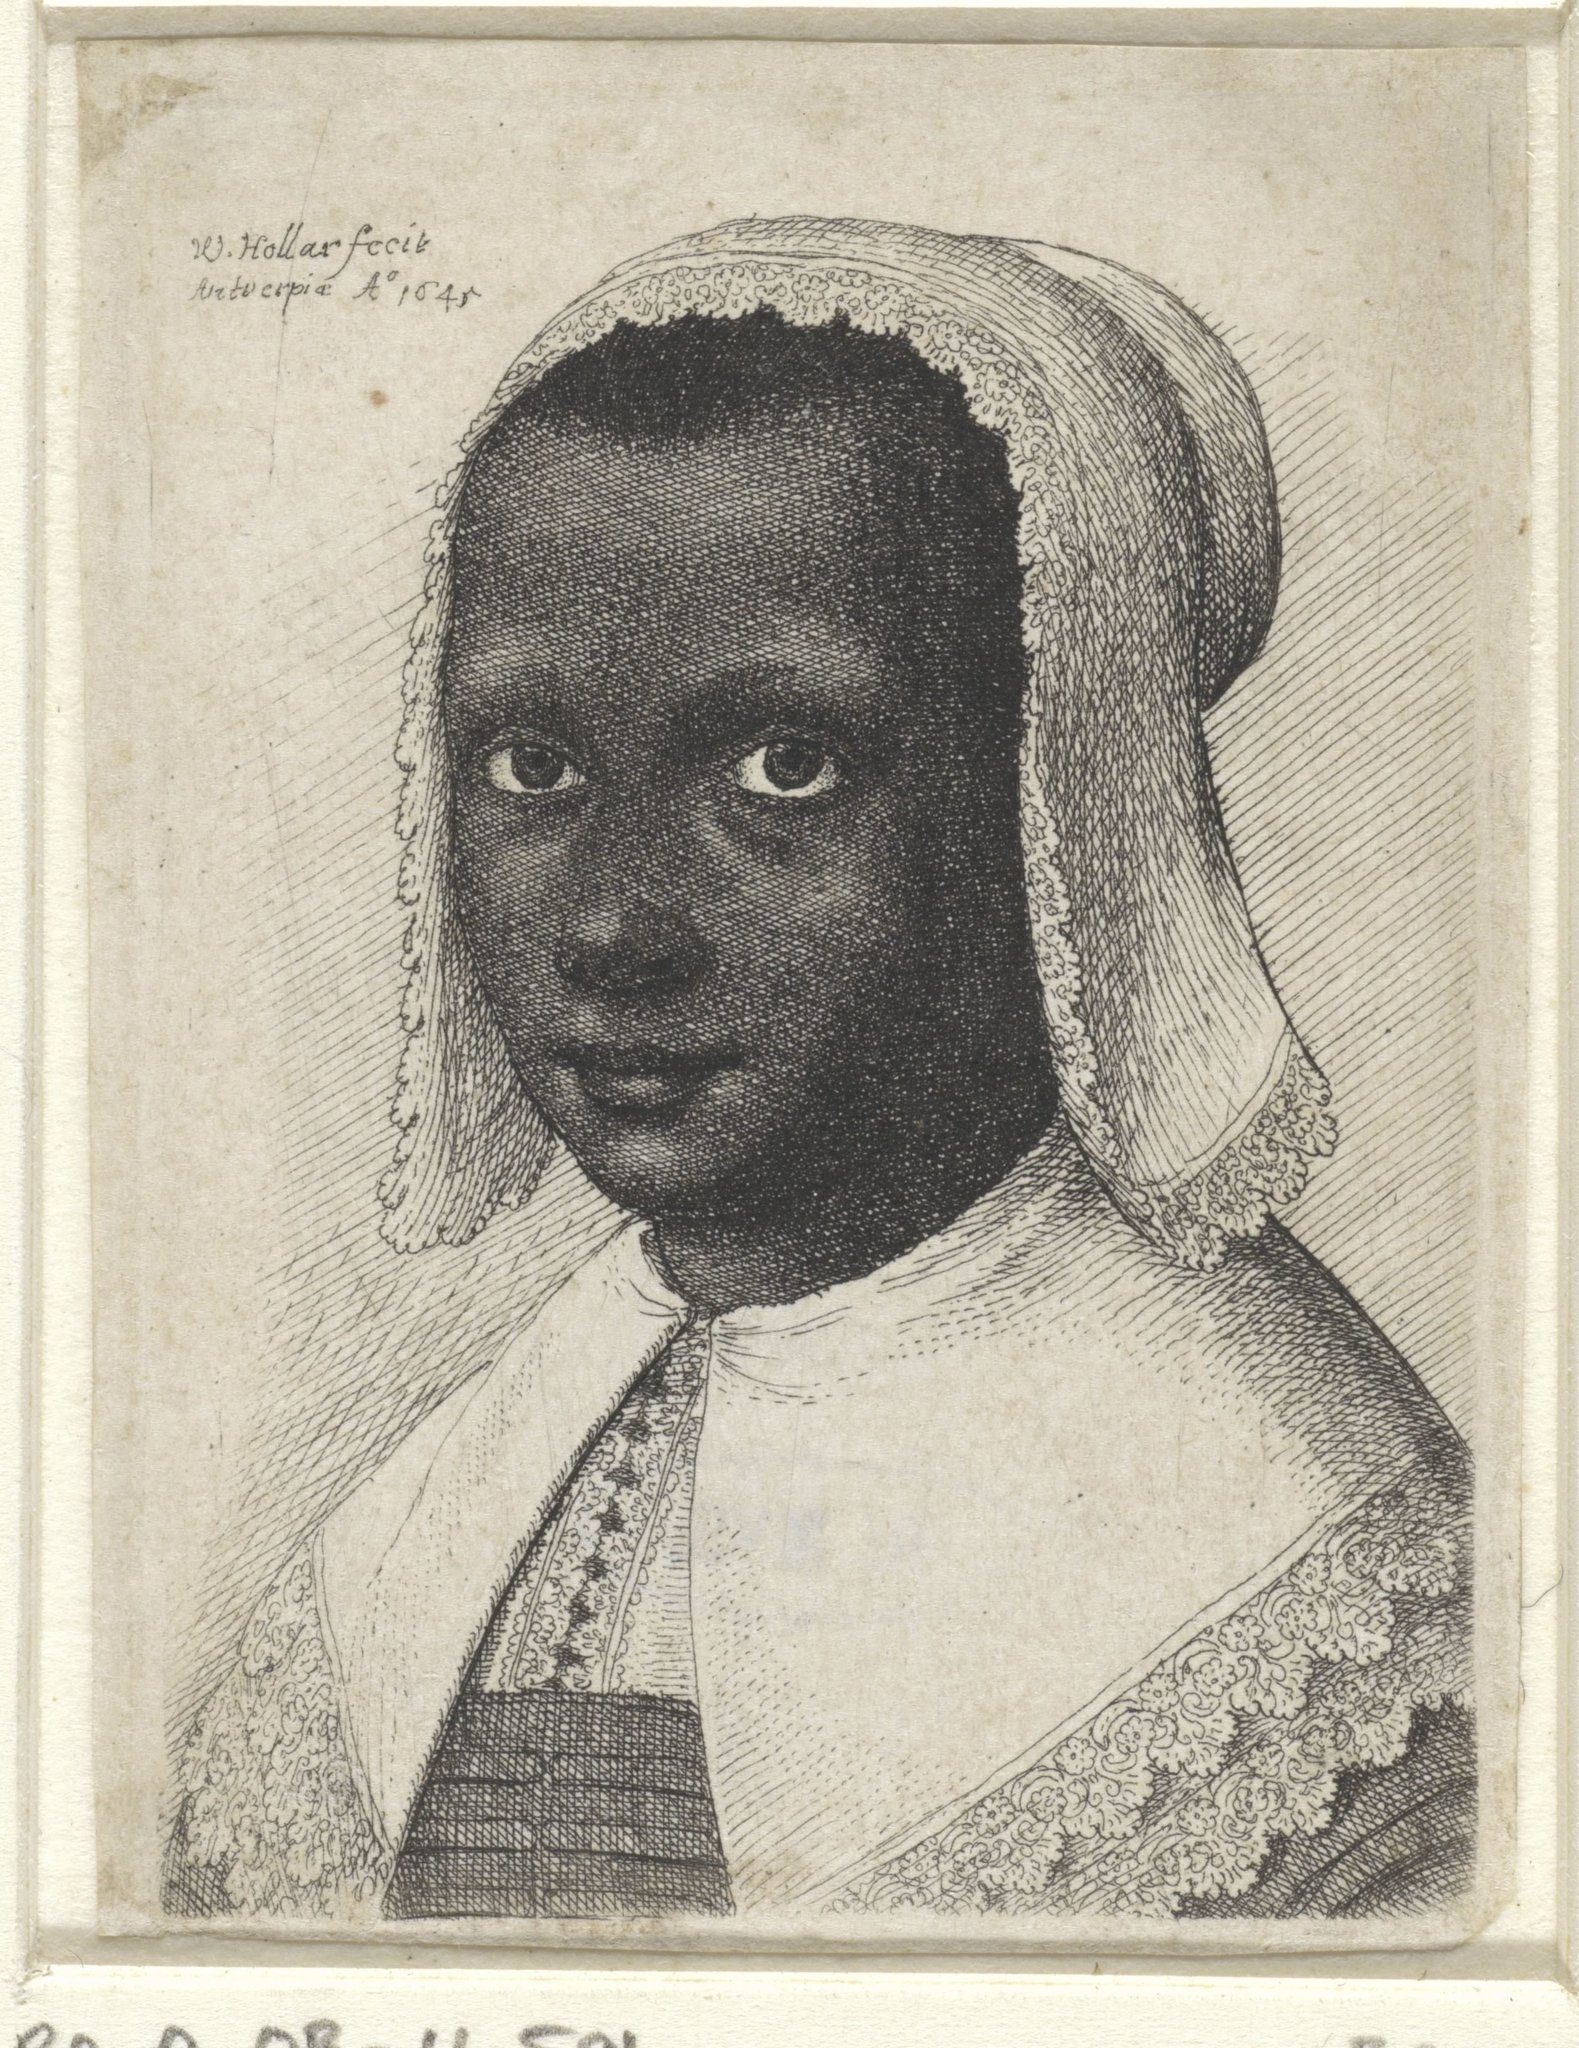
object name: print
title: Portret van een zwarte jonge vrouw met kanten hoofdkapje en bijpassende kraag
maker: wenceslaus hollar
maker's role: draughtsman, print maker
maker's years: 1607-1677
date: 1645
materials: paper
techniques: etching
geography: antwerp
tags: adolescent, young woman, maiden, africans, head-gear: cap (+ women's clothes), neck-gear: collar (+ women's clothes)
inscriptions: collector's mark: Lugt 2228